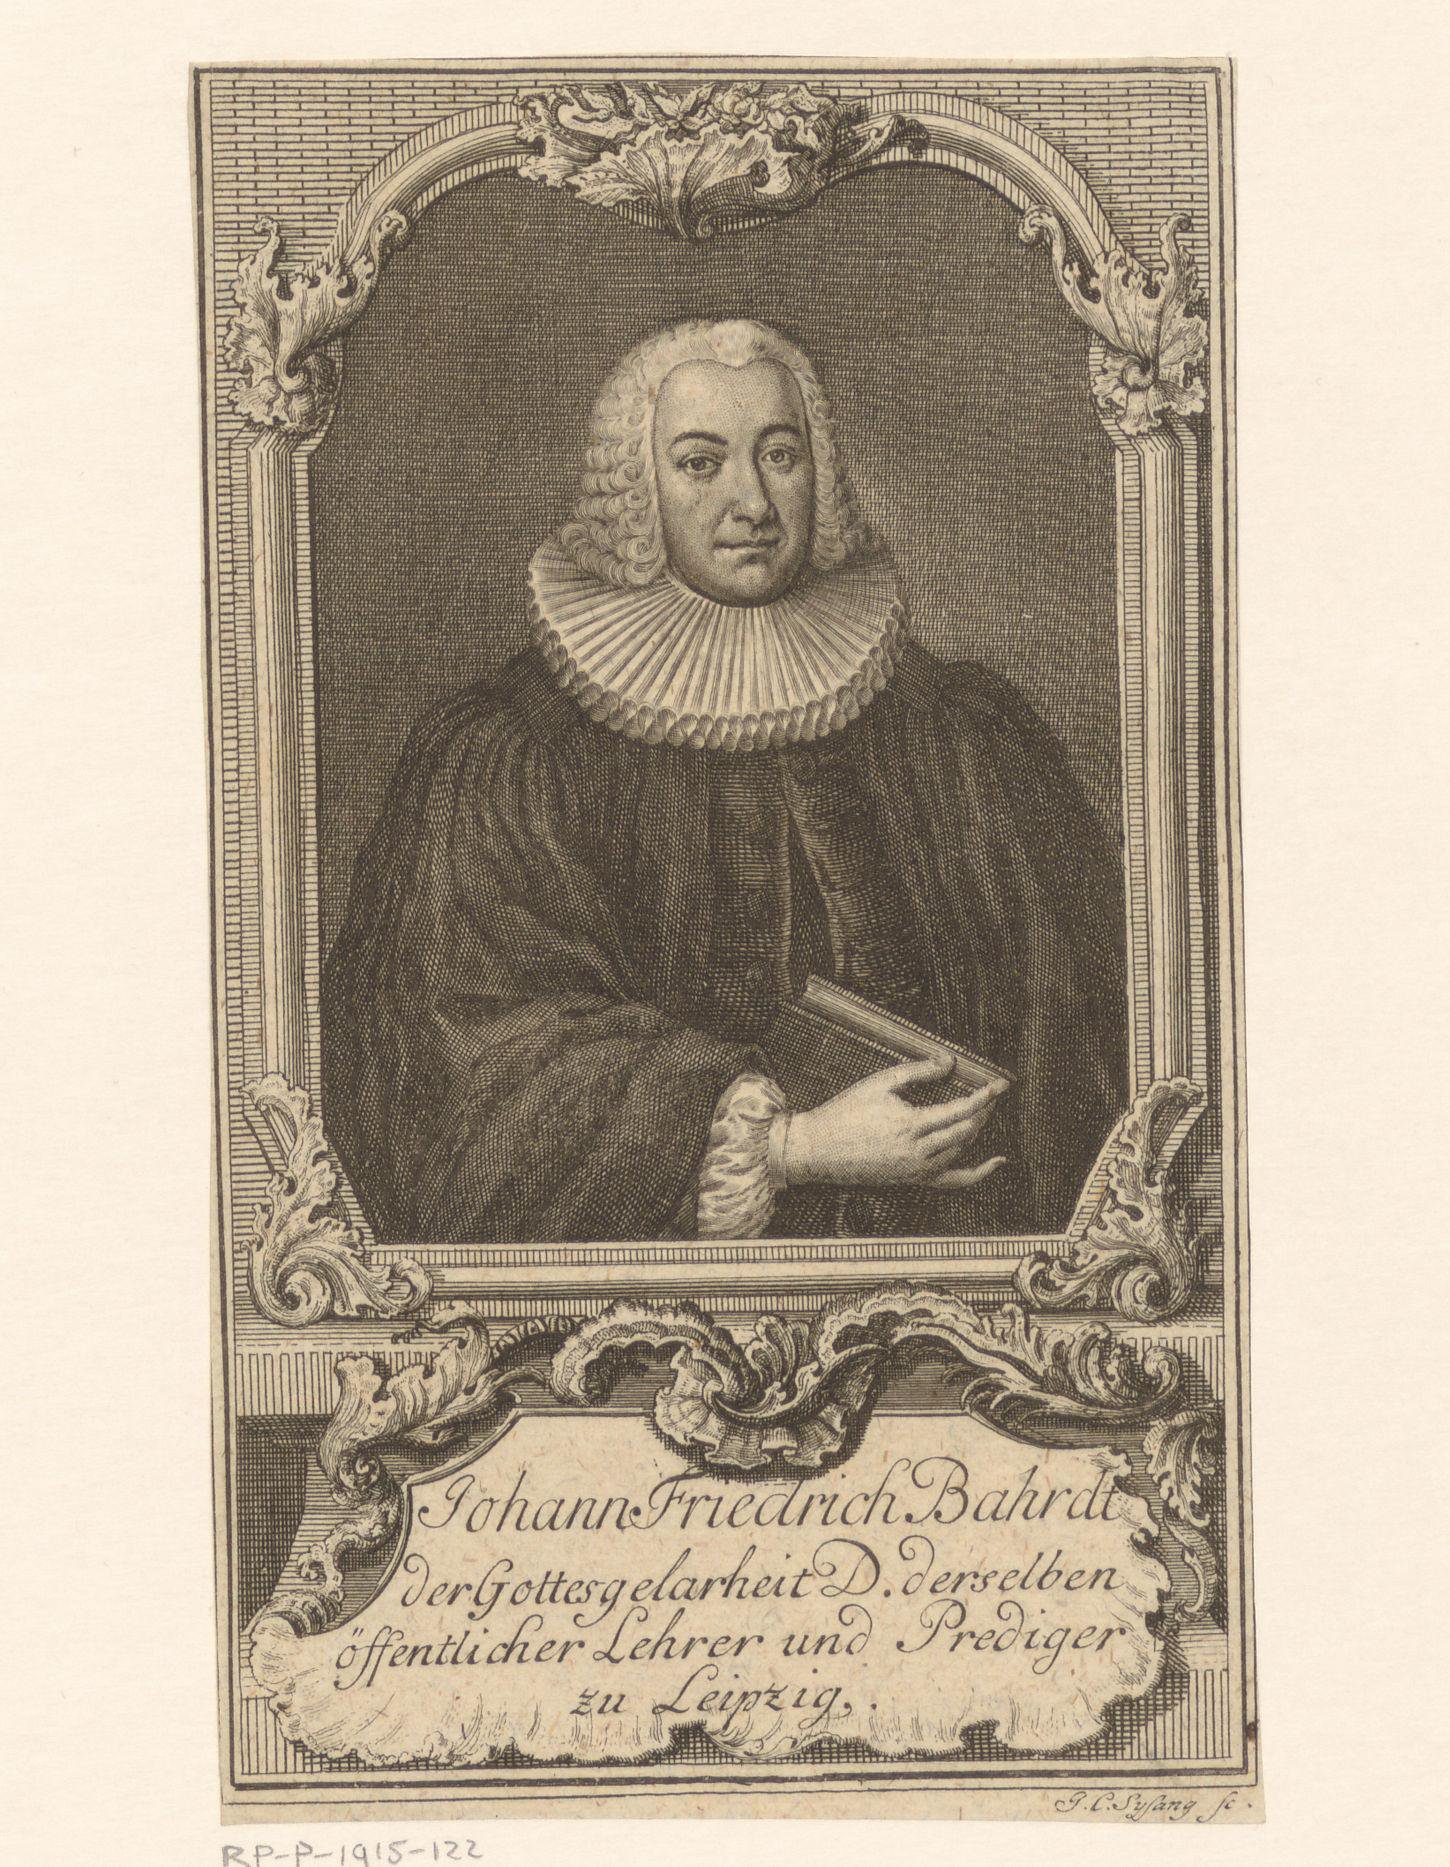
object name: print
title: Portret van Johann Friedrich Bahrdt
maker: johann christoph sysang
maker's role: print maker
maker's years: 1703-1757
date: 1735-1757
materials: paper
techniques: engraving, etching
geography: leipzig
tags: historical persons, book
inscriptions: collector's mark: Lugt 2233